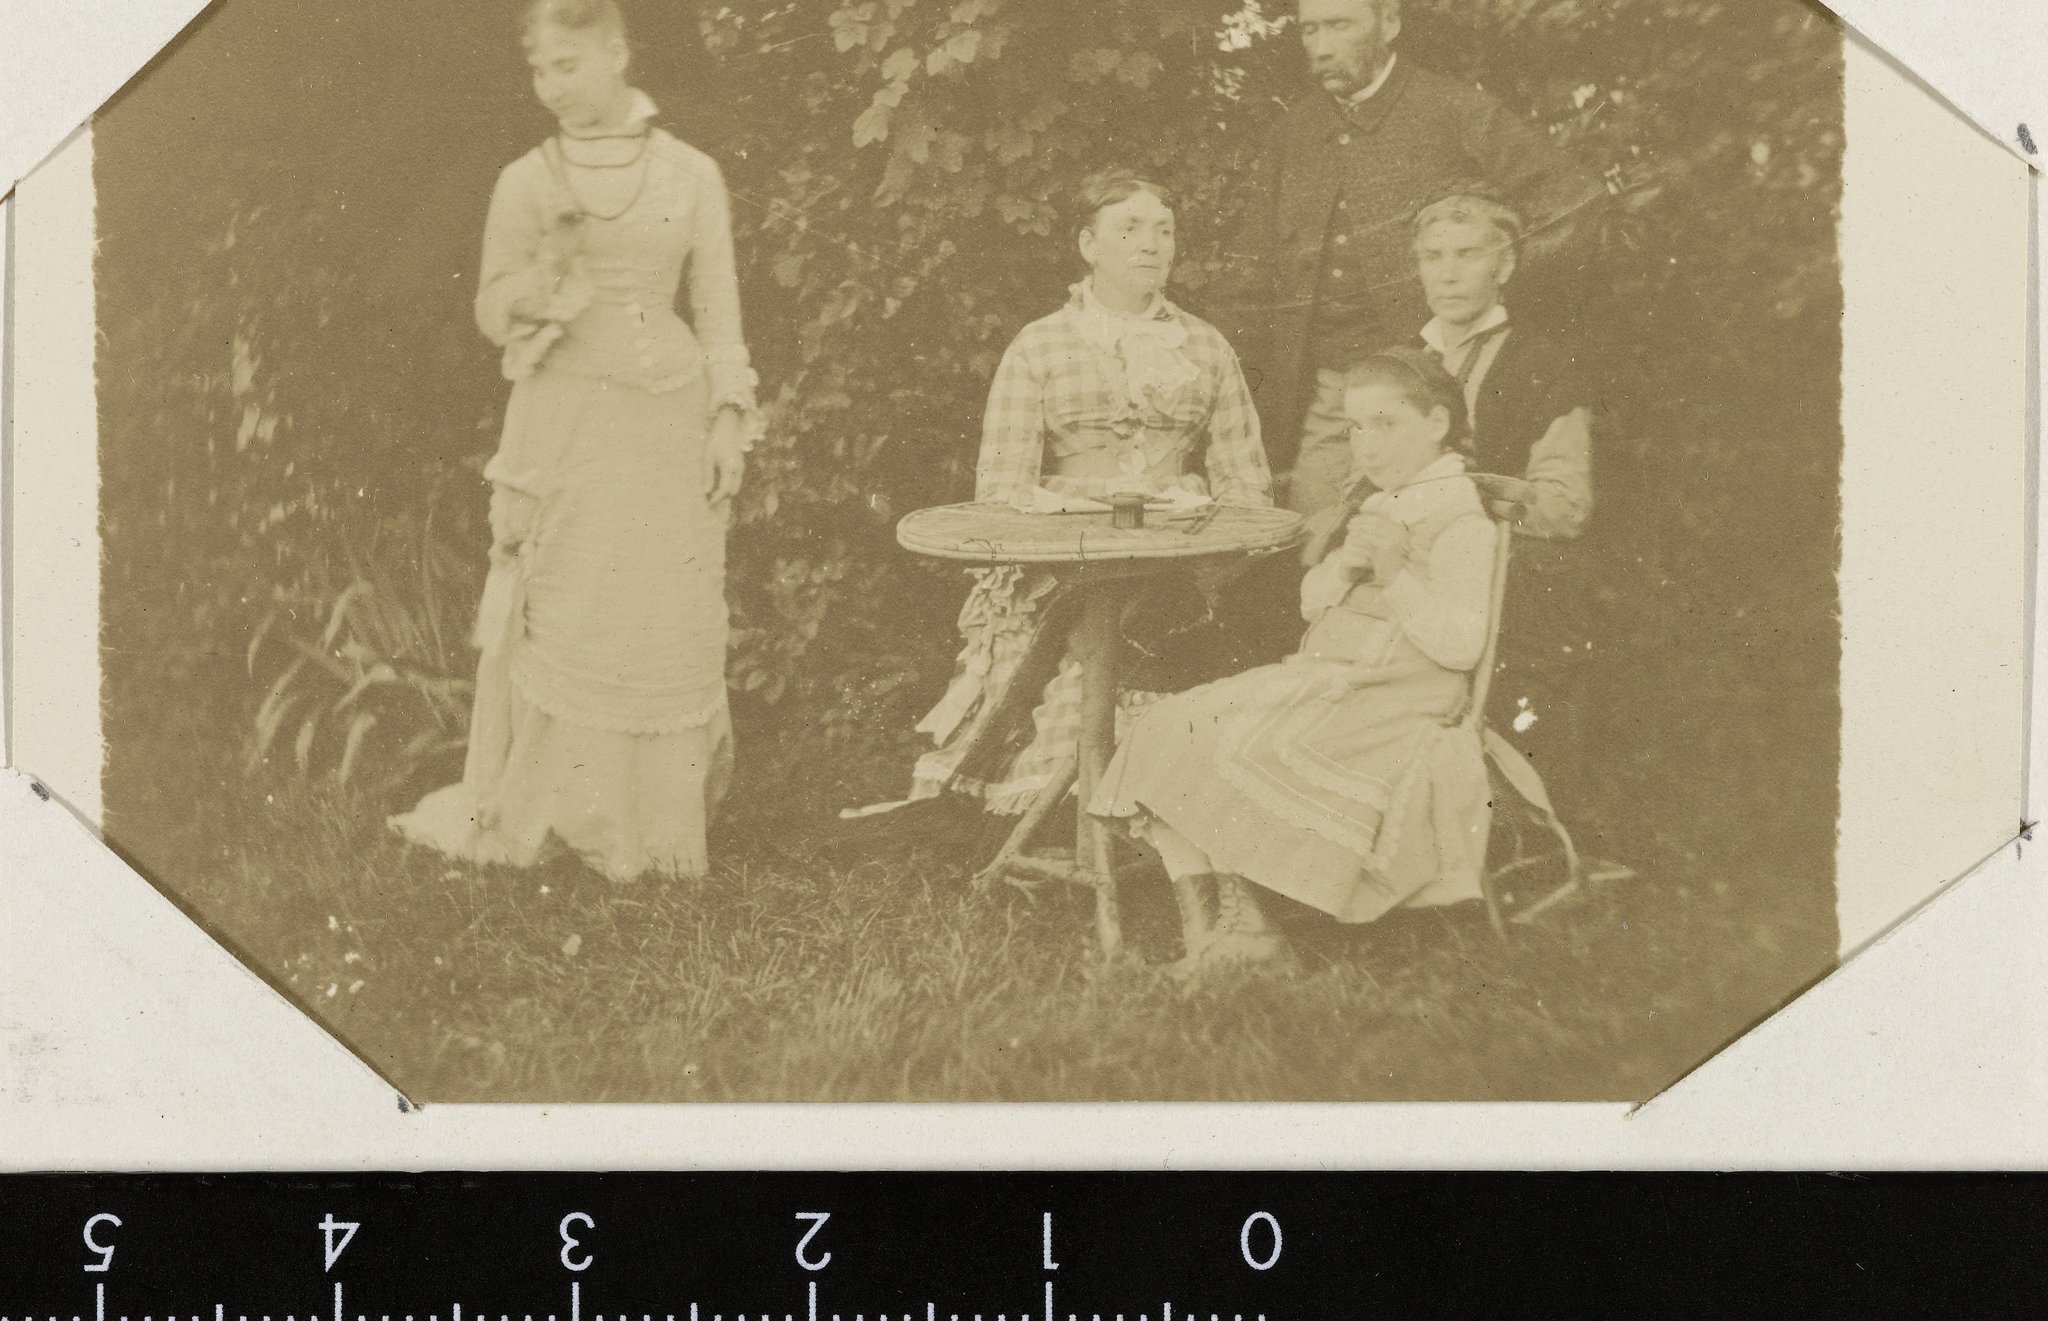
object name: photograph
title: Portret van een onbekende familie in een tuin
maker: Anonymous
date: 1878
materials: paper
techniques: gelatin silver print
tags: anonymous historical persons portrayed in a group, in a group-portrait - bb - woman